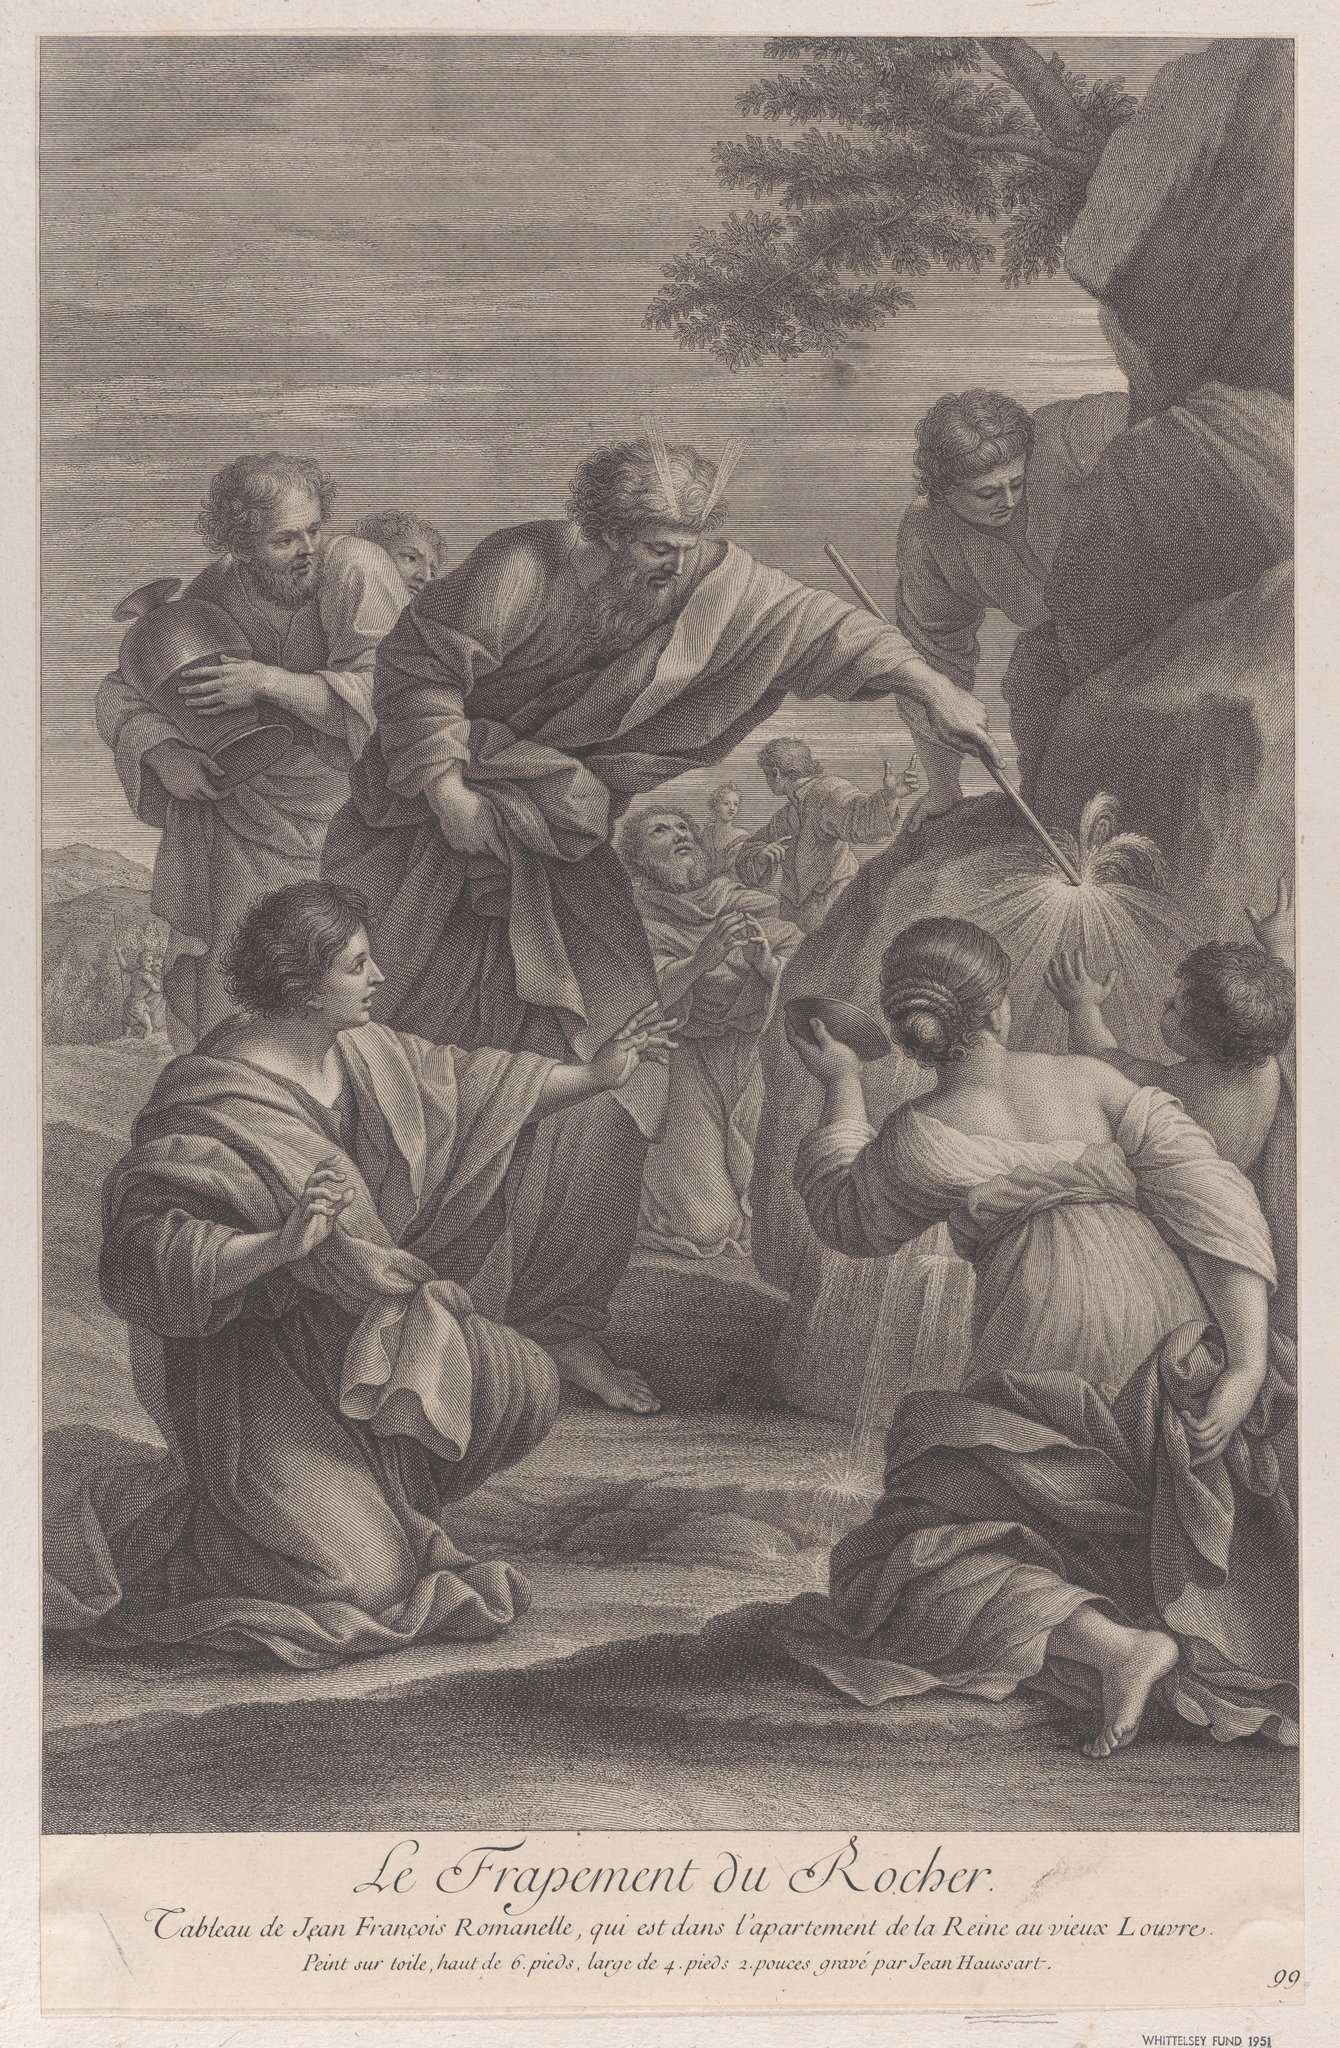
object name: print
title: Moses striking the rock with a stick to bring forth water, while the Israelites look on in amazement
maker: jean-baptiste haussard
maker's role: artist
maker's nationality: french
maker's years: 1679-1749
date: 1729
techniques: engraving, etching